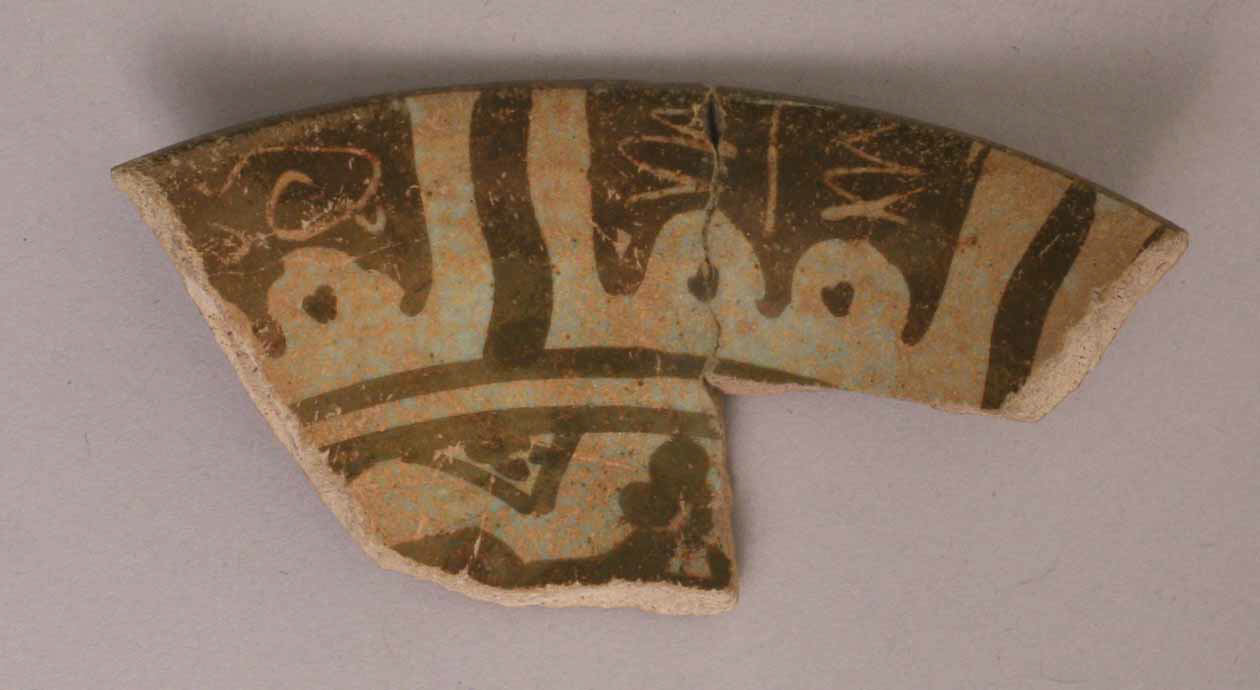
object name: ceramic fragment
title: Fragment of Bowl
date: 1001-1200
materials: stonepaste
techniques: glazing, luster painting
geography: syria